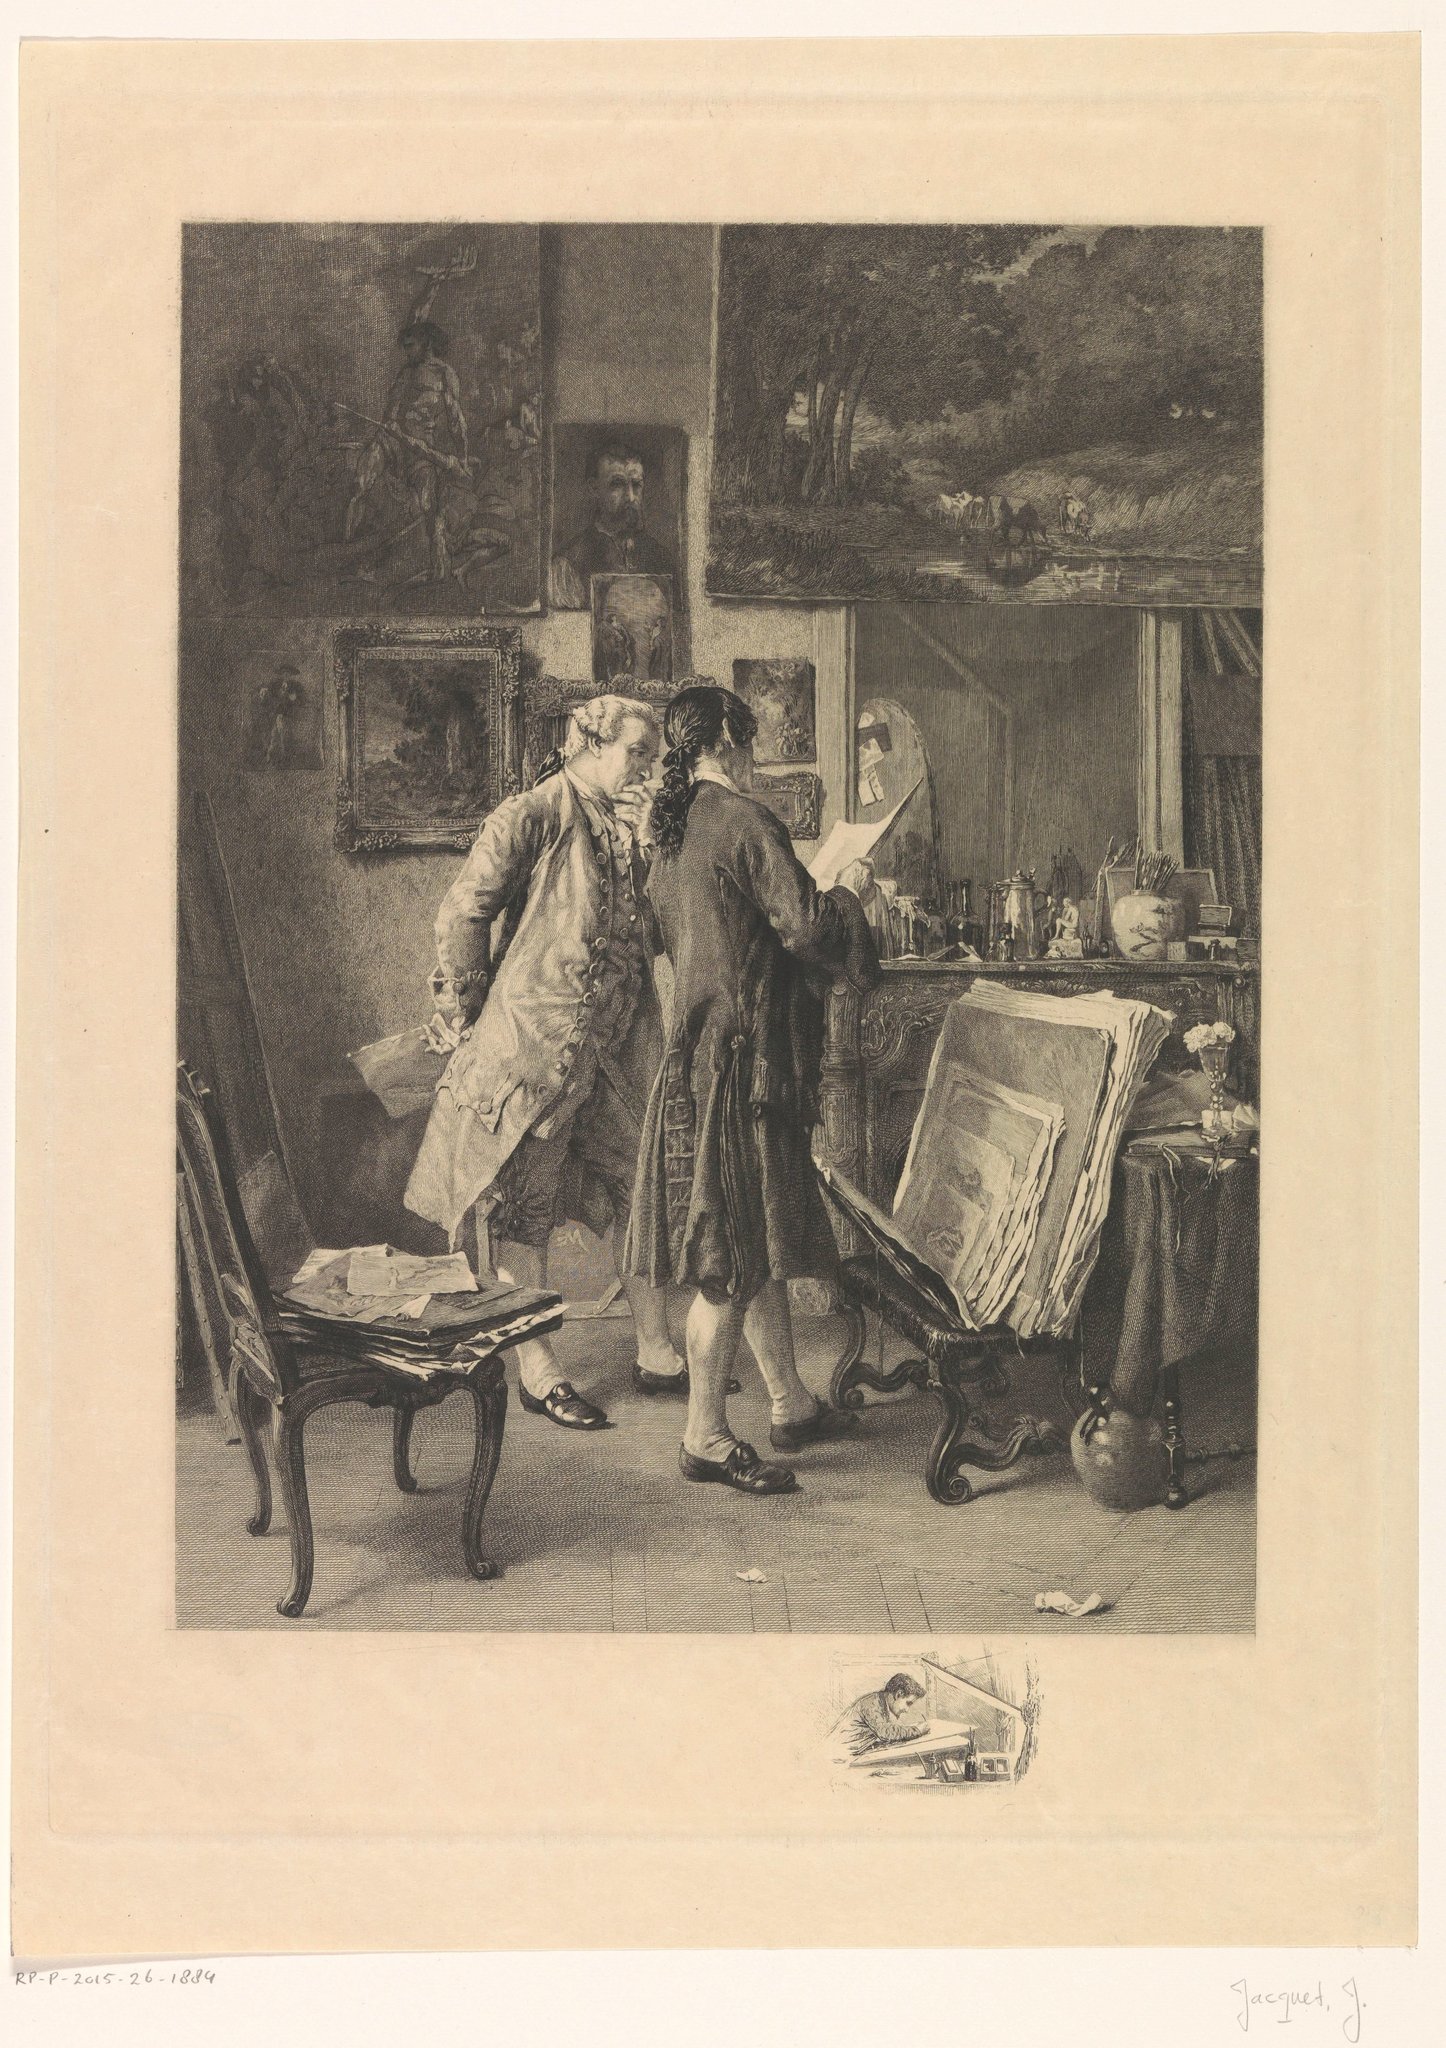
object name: print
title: Twee mannen bekijken prenten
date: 1851-1913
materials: paper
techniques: etching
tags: print, e.g.: engraving, etching, lithograph, art collector (+ graphic arts), picture, painting, artist at work, in his workshop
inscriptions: collector's mark: Lugt 2228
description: Interieur met twee mannen in achttiende-eeuwse kleding die prenten bekijken. Aan de muur hangen schilderijen. Onder de afbeelding een 'remarque' van een tekenaar of prentmaker achter zijn werktafel.